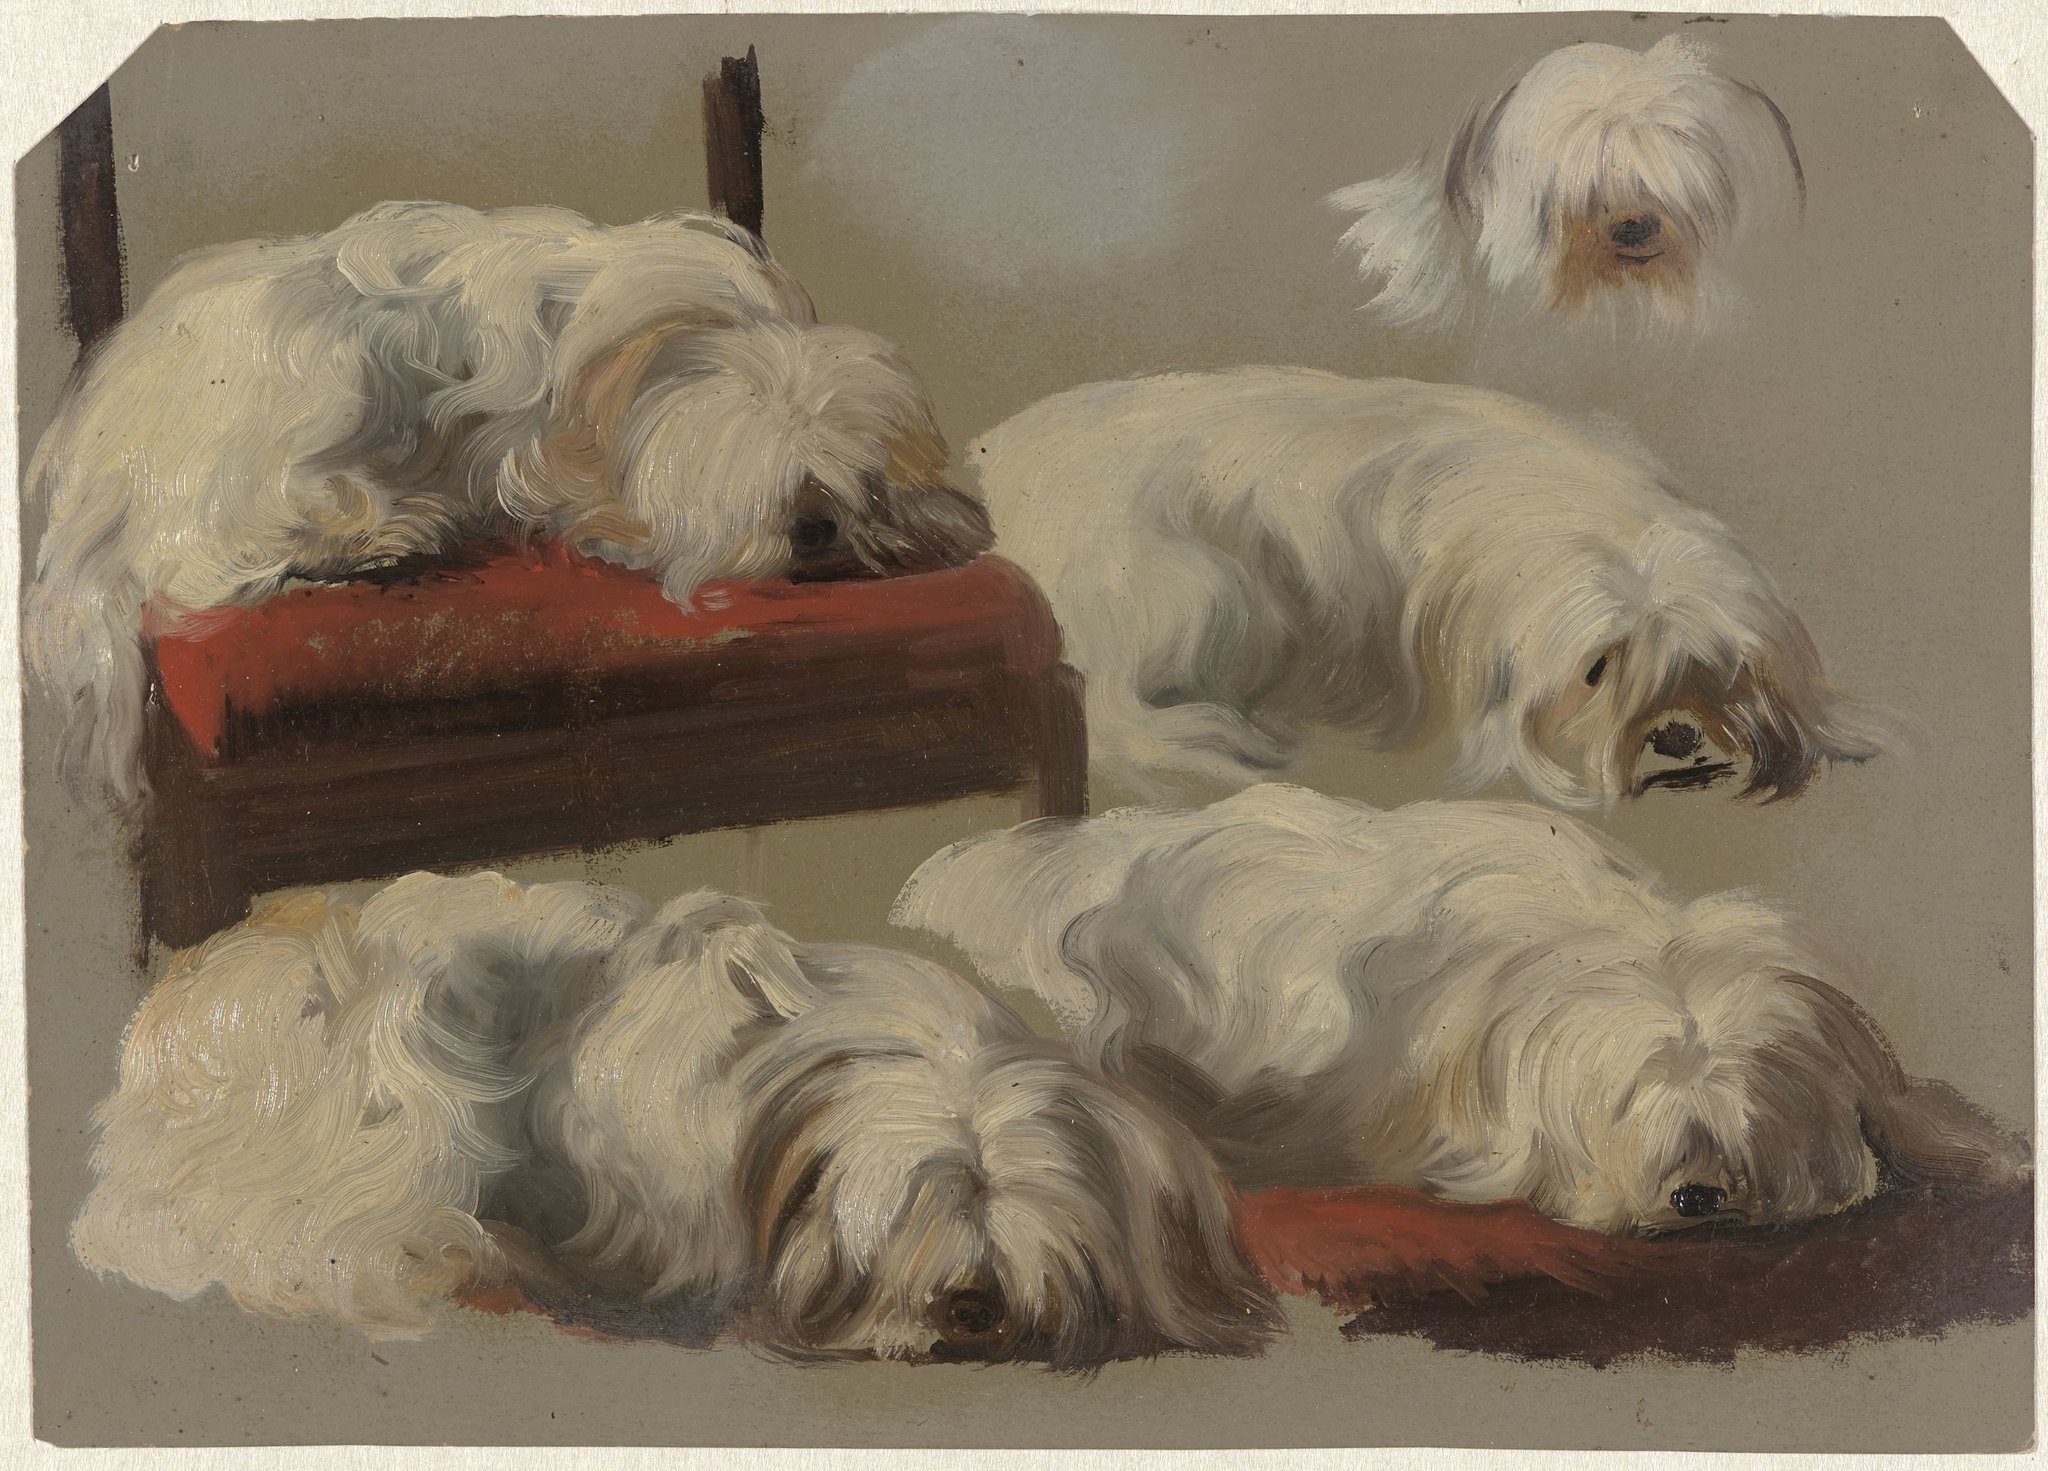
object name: drawing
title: Studies van een wit schoothondje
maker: guillaume anne van der brugghen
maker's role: draughtsman, print maker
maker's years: 1812-1891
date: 1821-1891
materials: oil, paper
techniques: brush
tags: dog